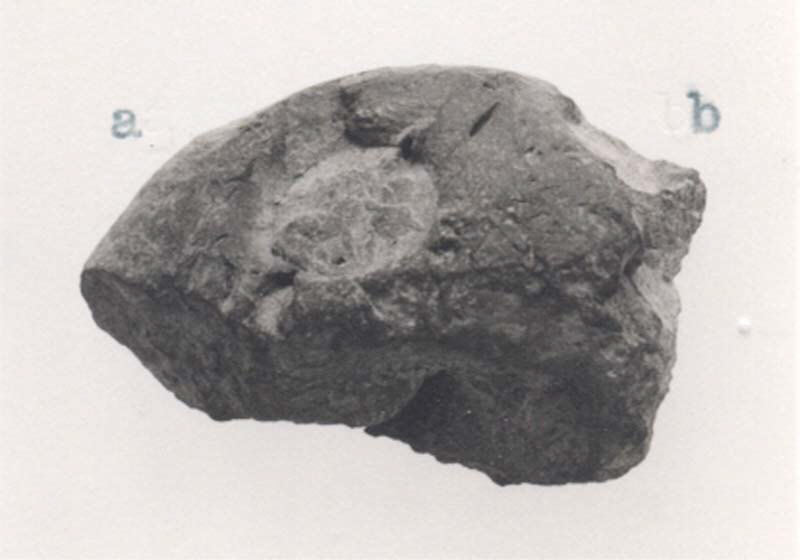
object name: sealing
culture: sasanian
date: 601-700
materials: clay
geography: iran